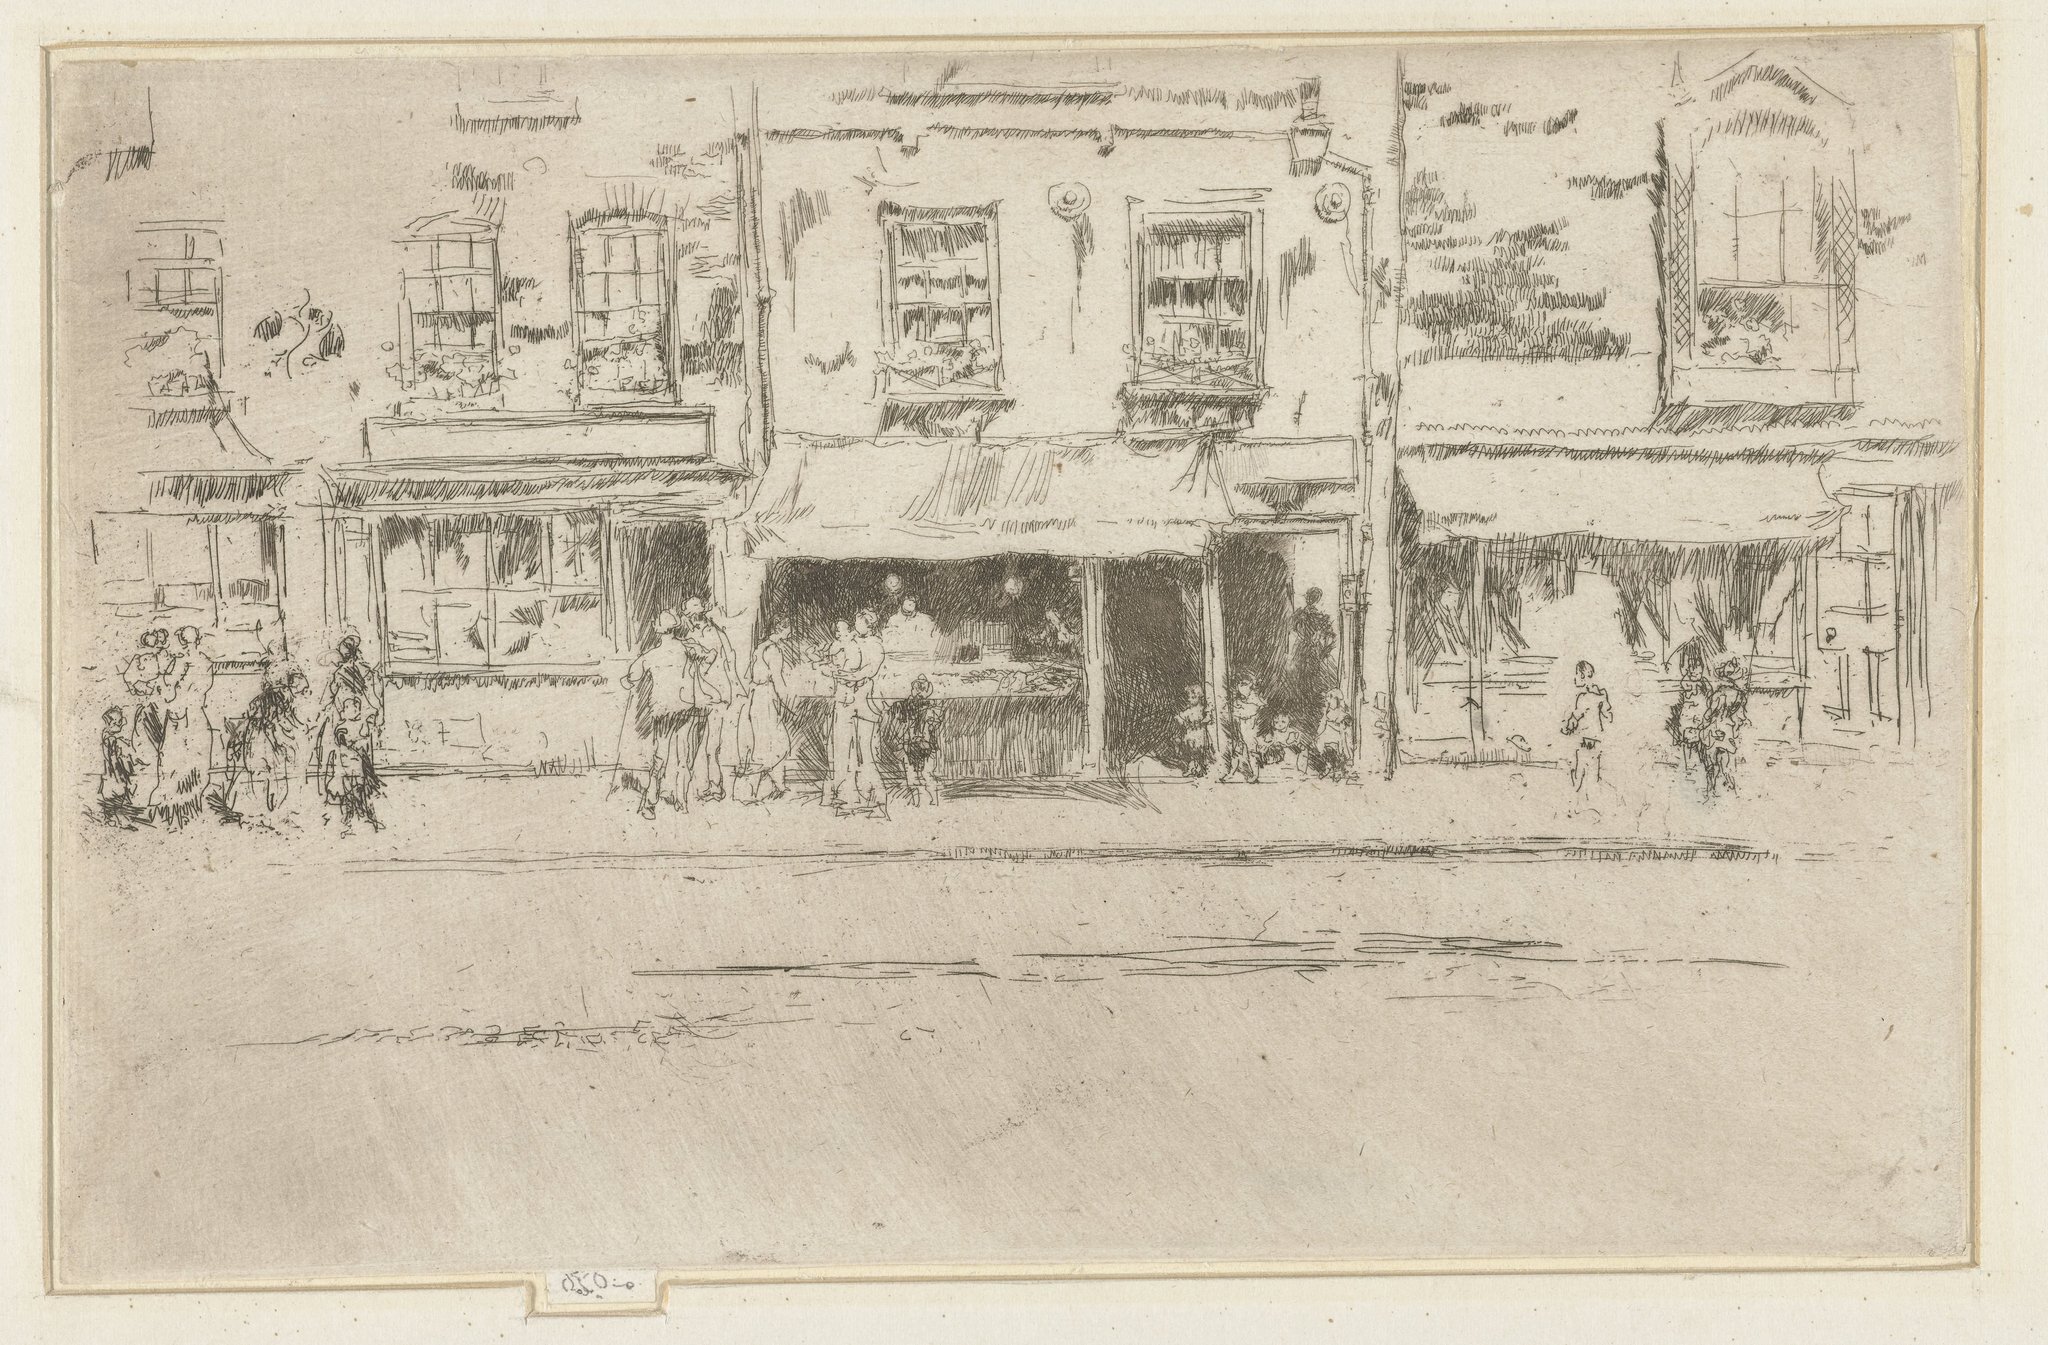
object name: print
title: The Fish-Shop, Busy Chelsea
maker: james abbott mcneill whistler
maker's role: painter, print maker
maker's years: 1834-1903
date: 1884-1886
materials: paper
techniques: etching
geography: england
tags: shop, store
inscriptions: collector's mark: Lugt 2166, signature: ‘JW imp’, collector's mark: Lugt 2760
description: Een straat met een rij huizen, in het midden een viswinkel.